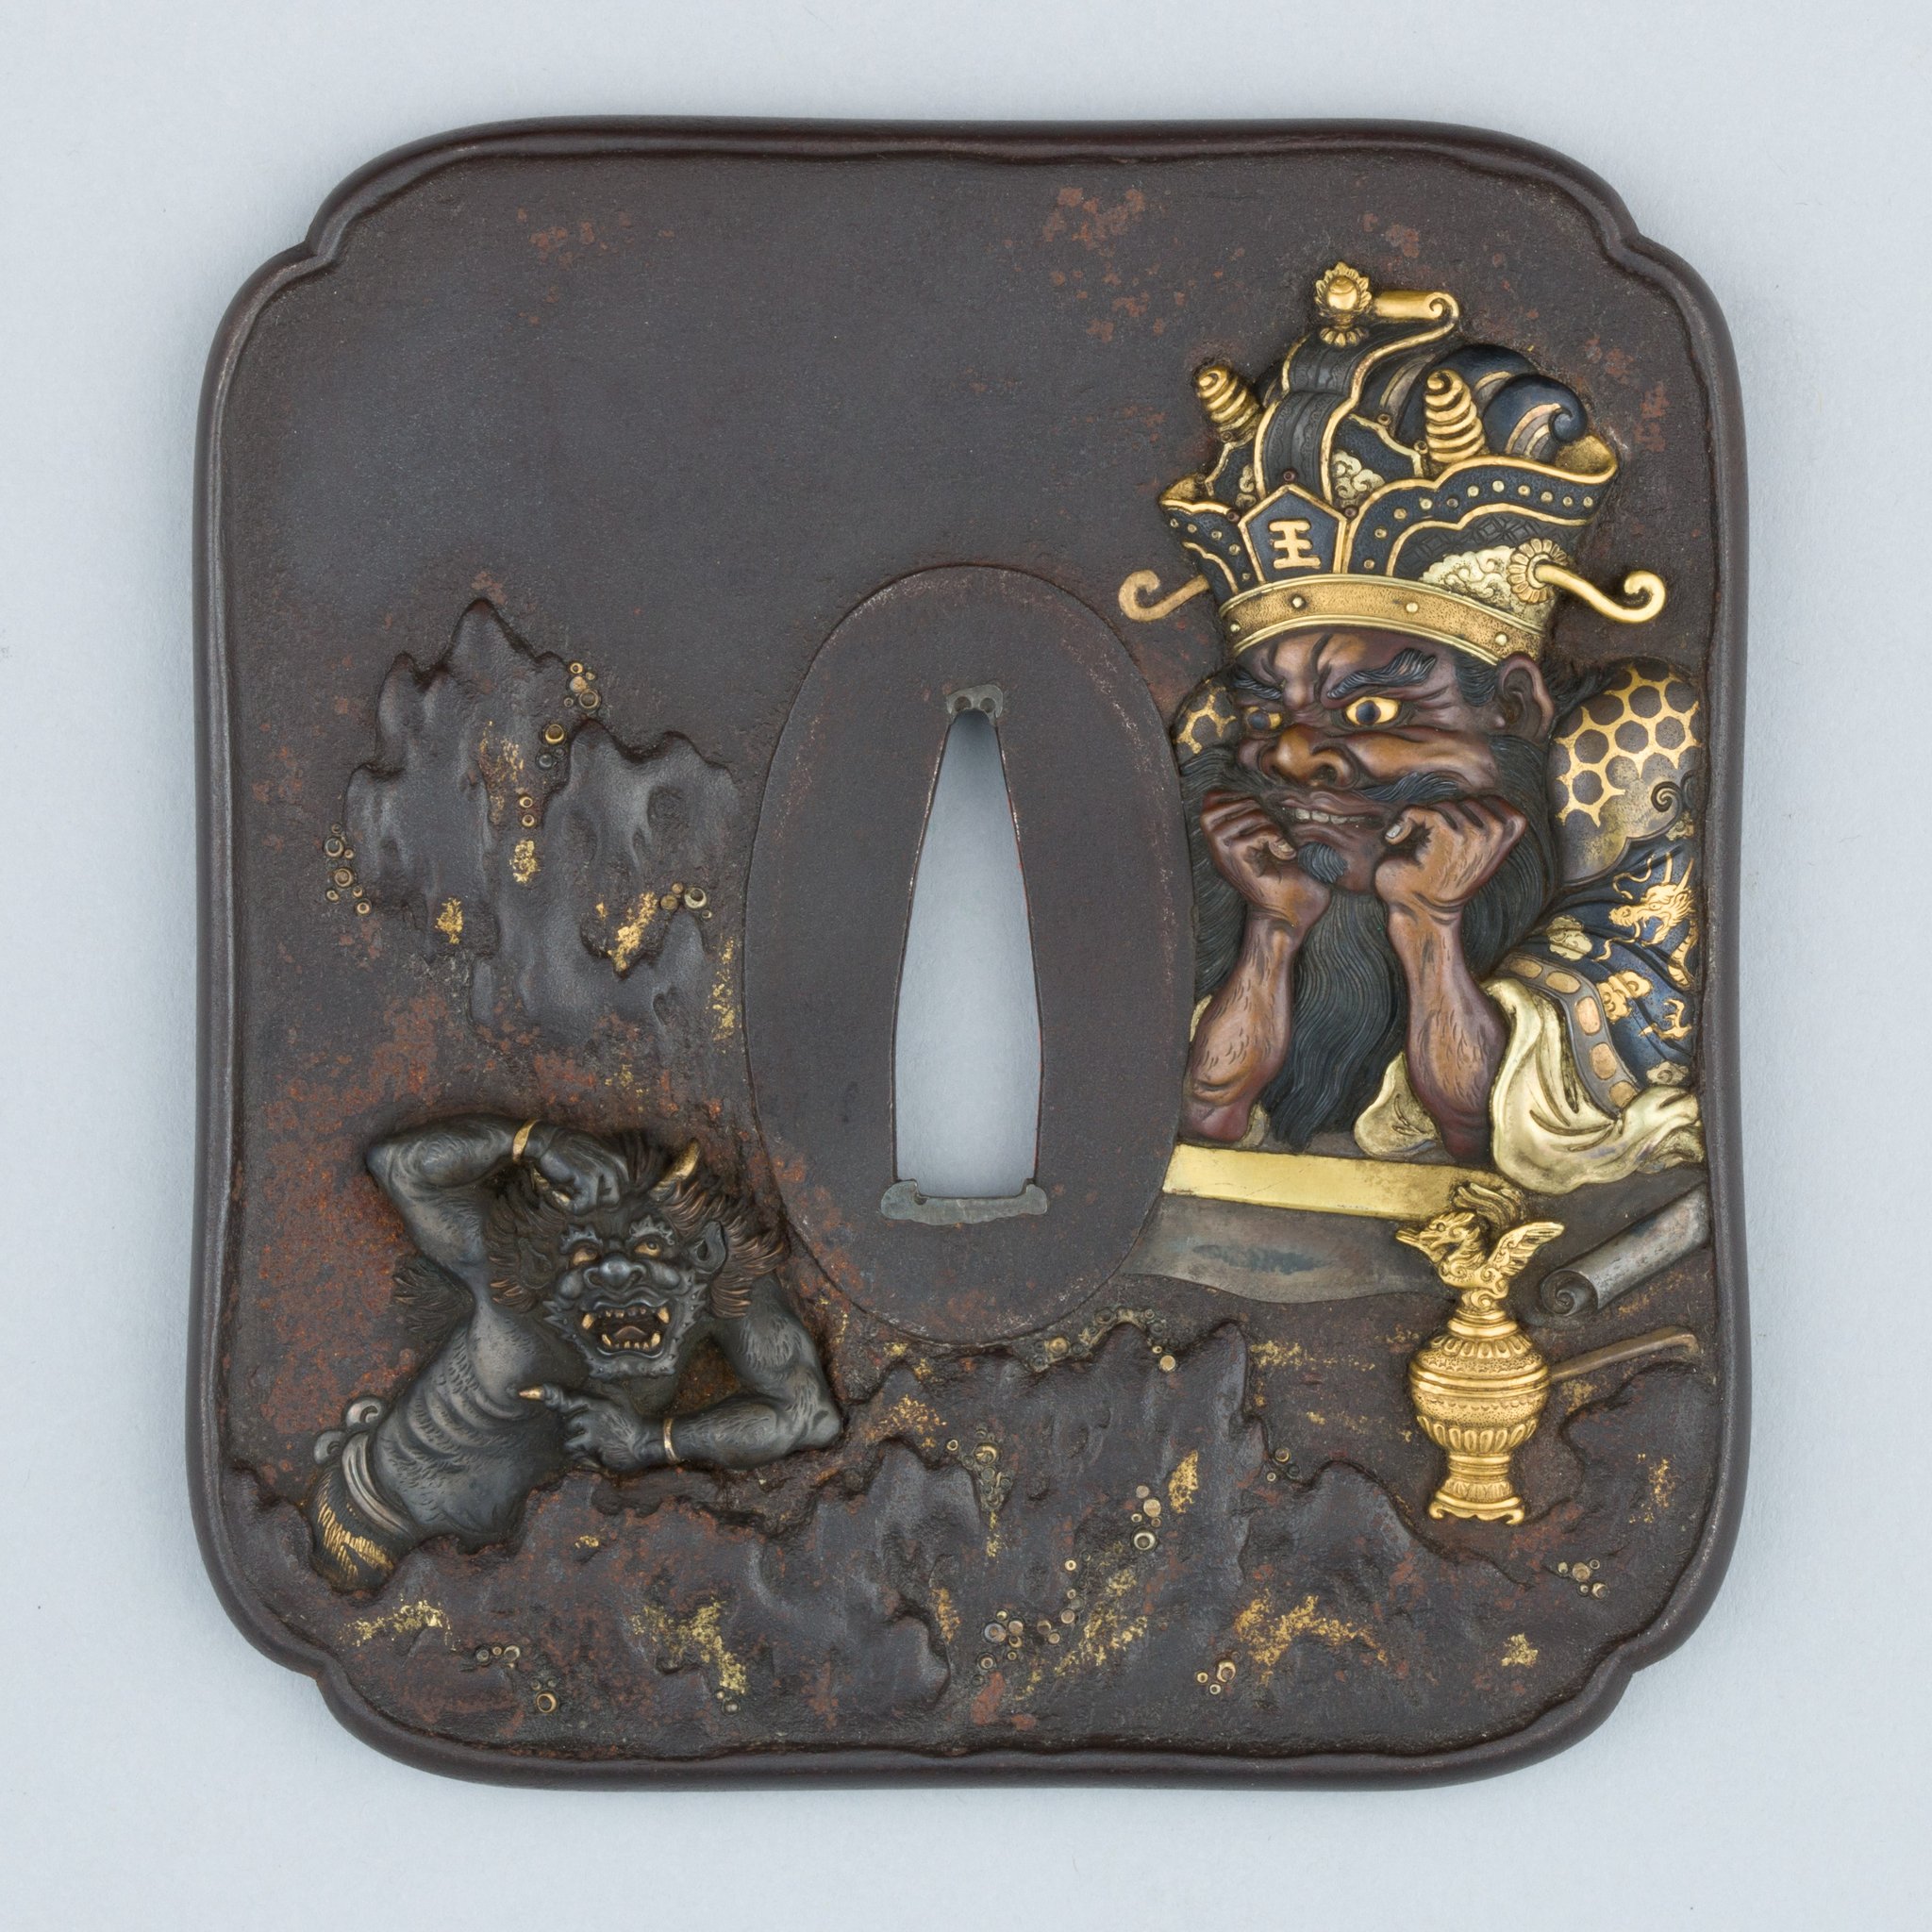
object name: sword guard tsuba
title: Sword Guard (Tsuba)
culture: japanese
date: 1615-1868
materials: copper, silver alloy, gold, iron, silver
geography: japan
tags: men